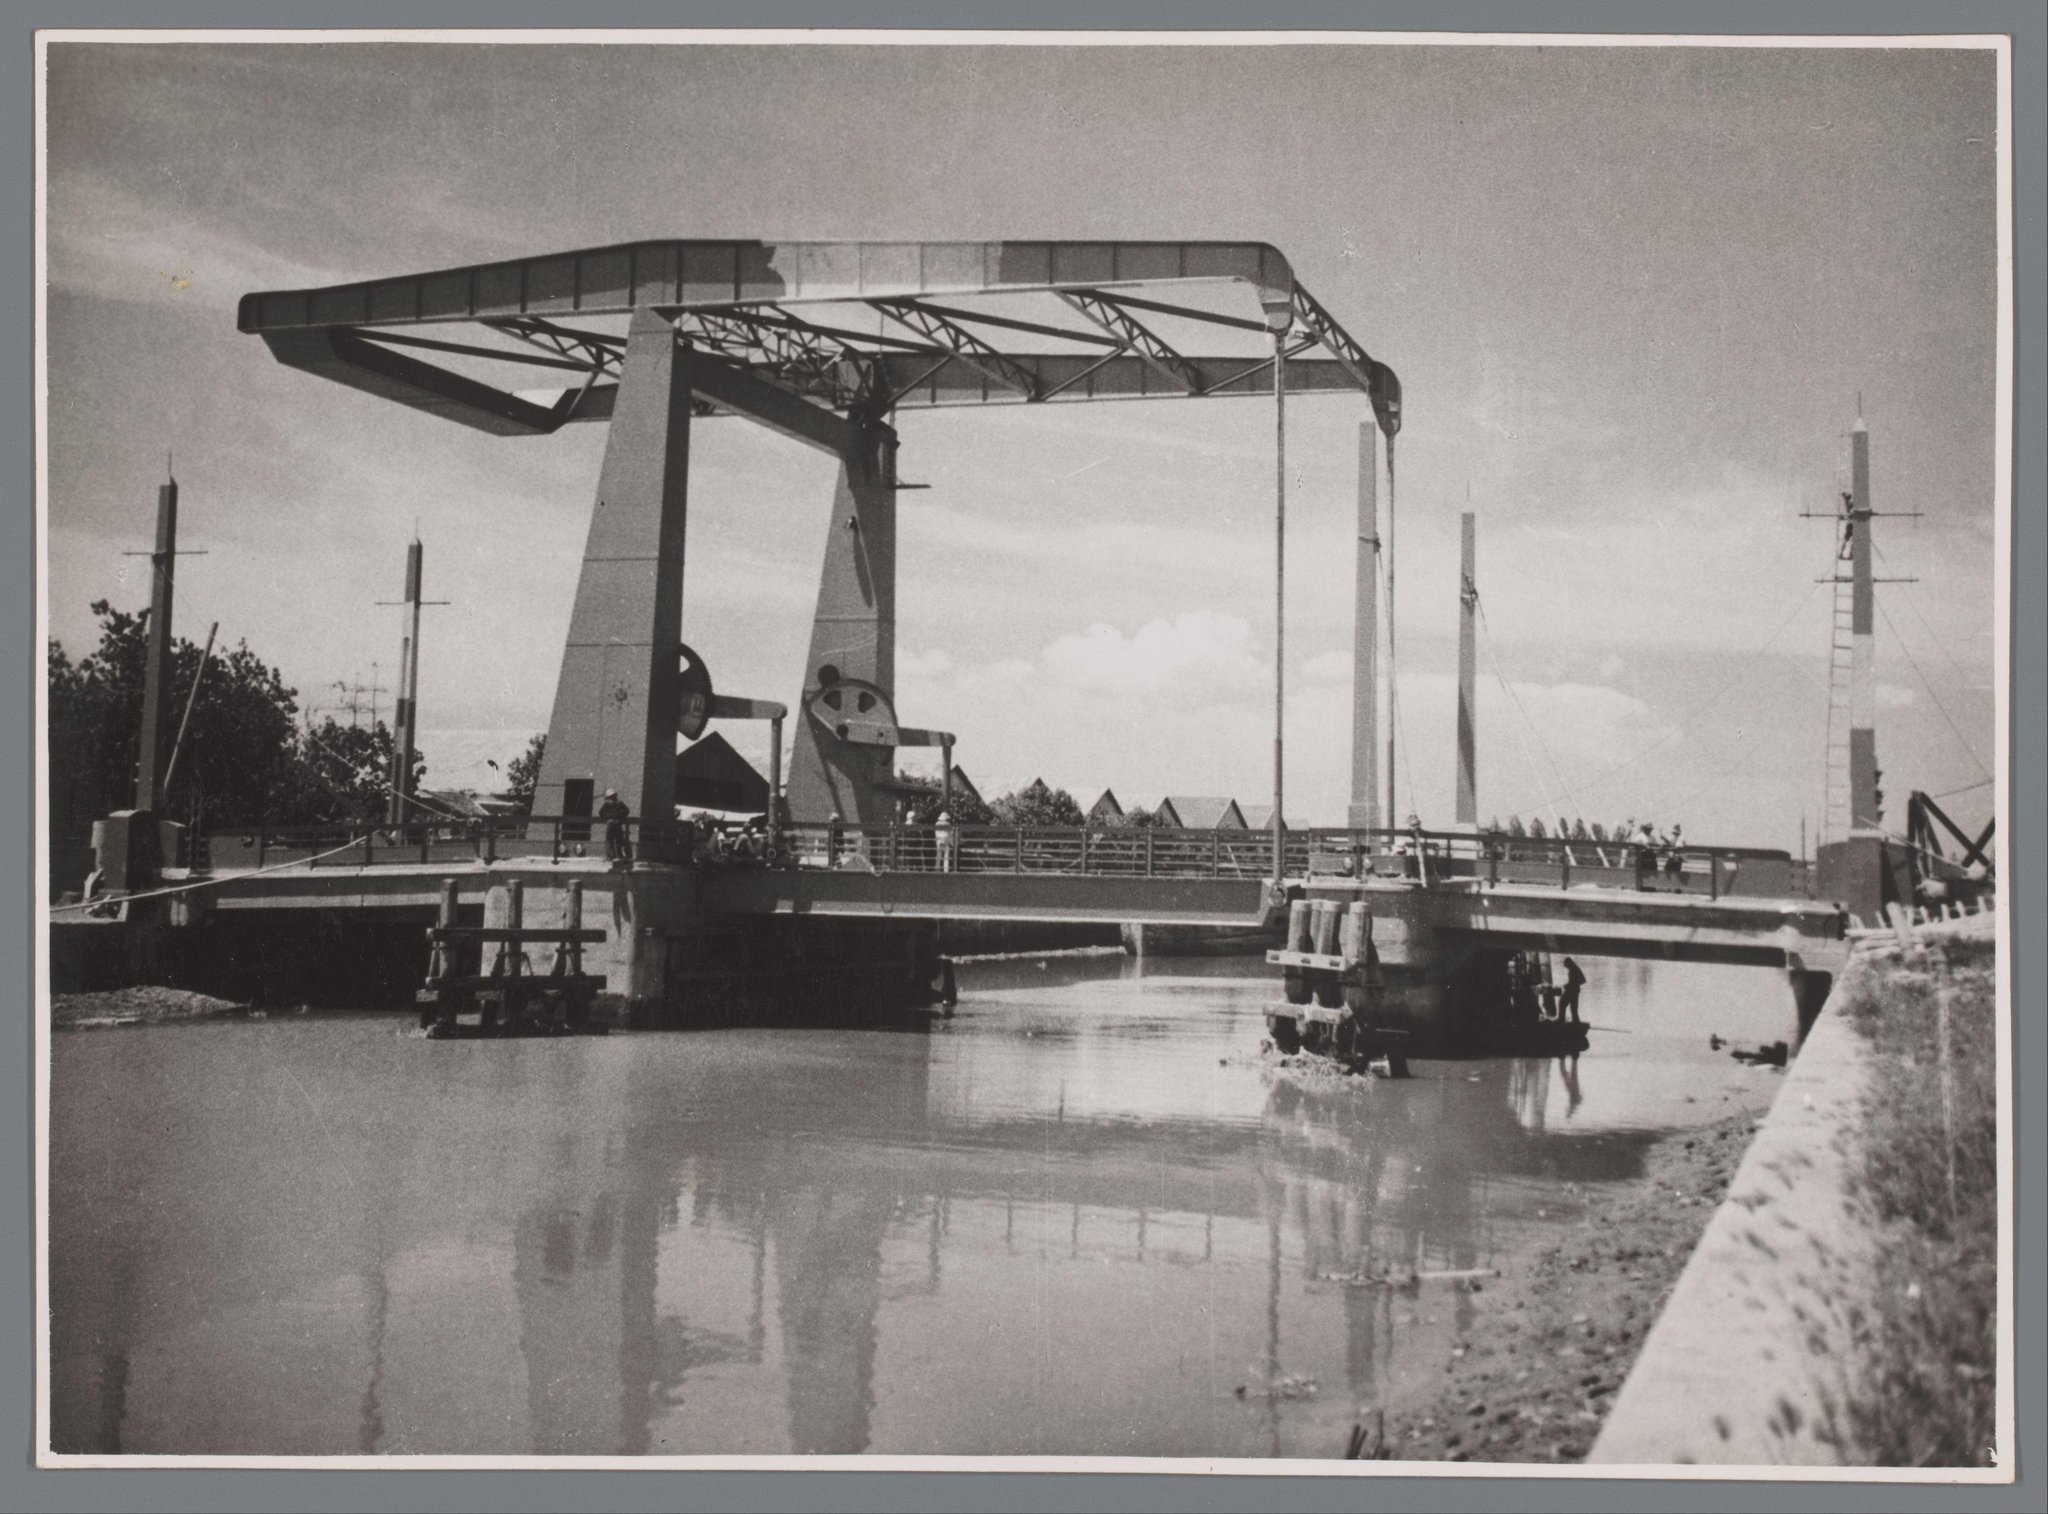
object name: photograph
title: Admiraal Ferwerdabrug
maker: Anonymous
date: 1940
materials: photographic support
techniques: gelatin silver print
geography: surabaya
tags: colonial system, bascule bridge, java, surabaya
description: Ophaalbrug, de Admiraal Ferwerdabrug, over de Kali Mas in Soerabaja. Onderdeel van de multomap met foto's van bruggen gebouwd door de N.V. Machinefabriek Braat te Soerabaja en bestemd voor verschillende plaatsen in Nederlands-Indië, uit de periode 1931-1940.